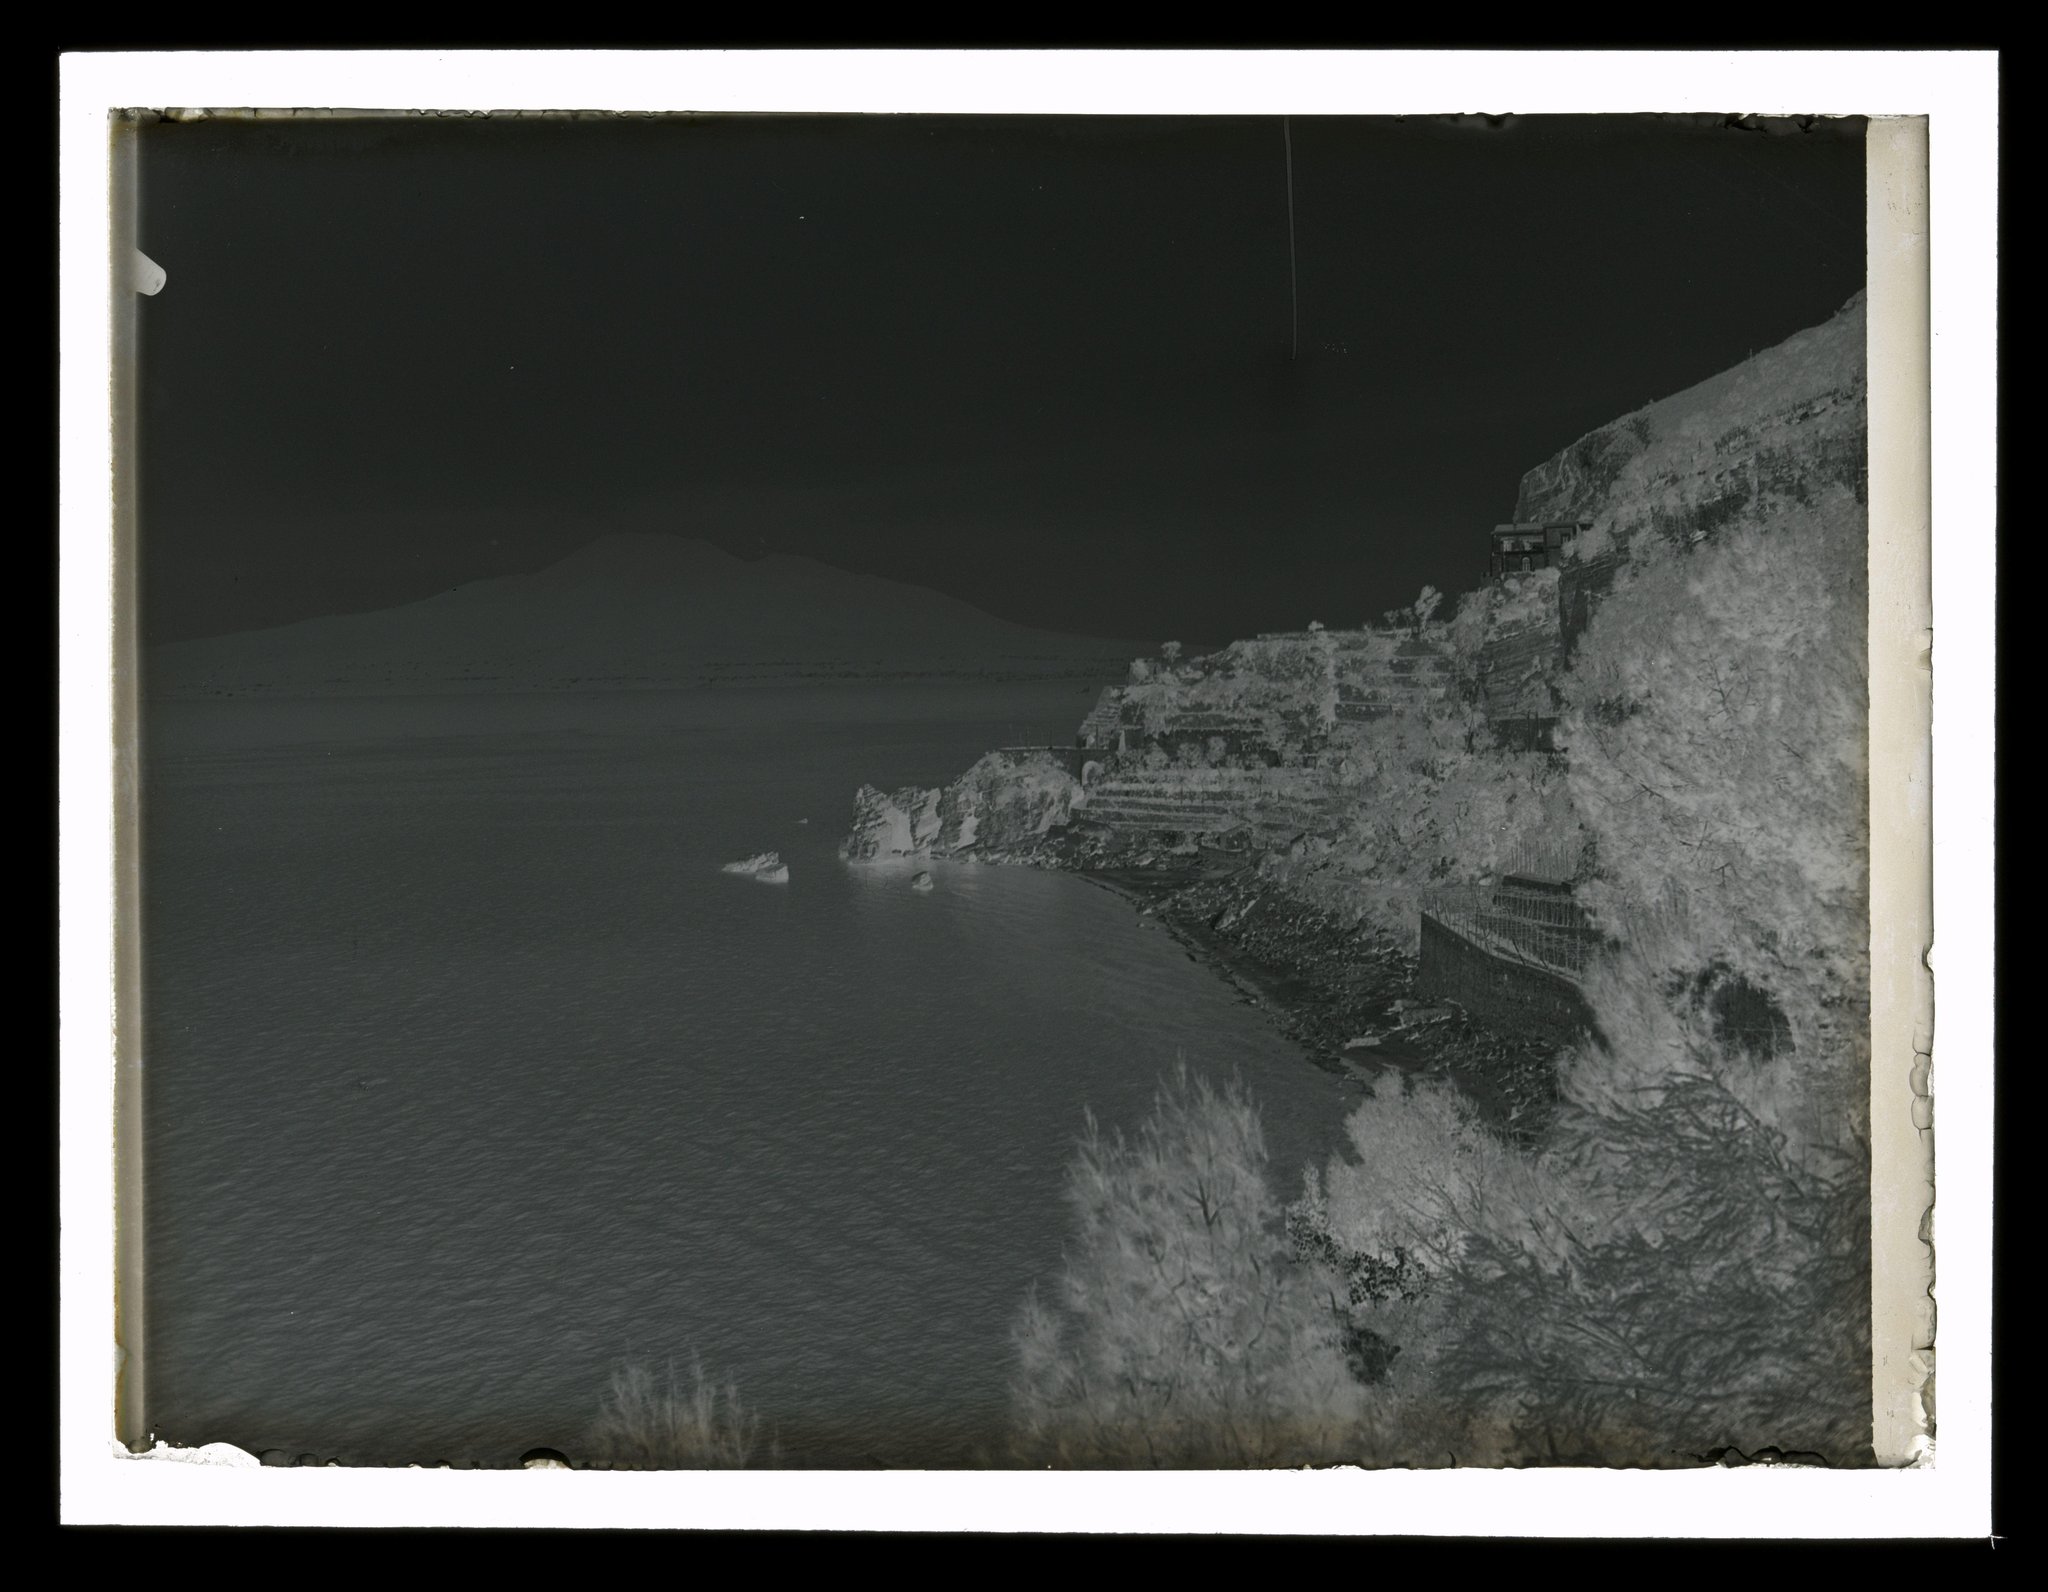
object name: photograph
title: Kustgezicht in Sorrento of Capri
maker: Anonymous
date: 1907-1935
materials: glass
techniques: gelatin glass negative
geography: campania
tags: coast, campania